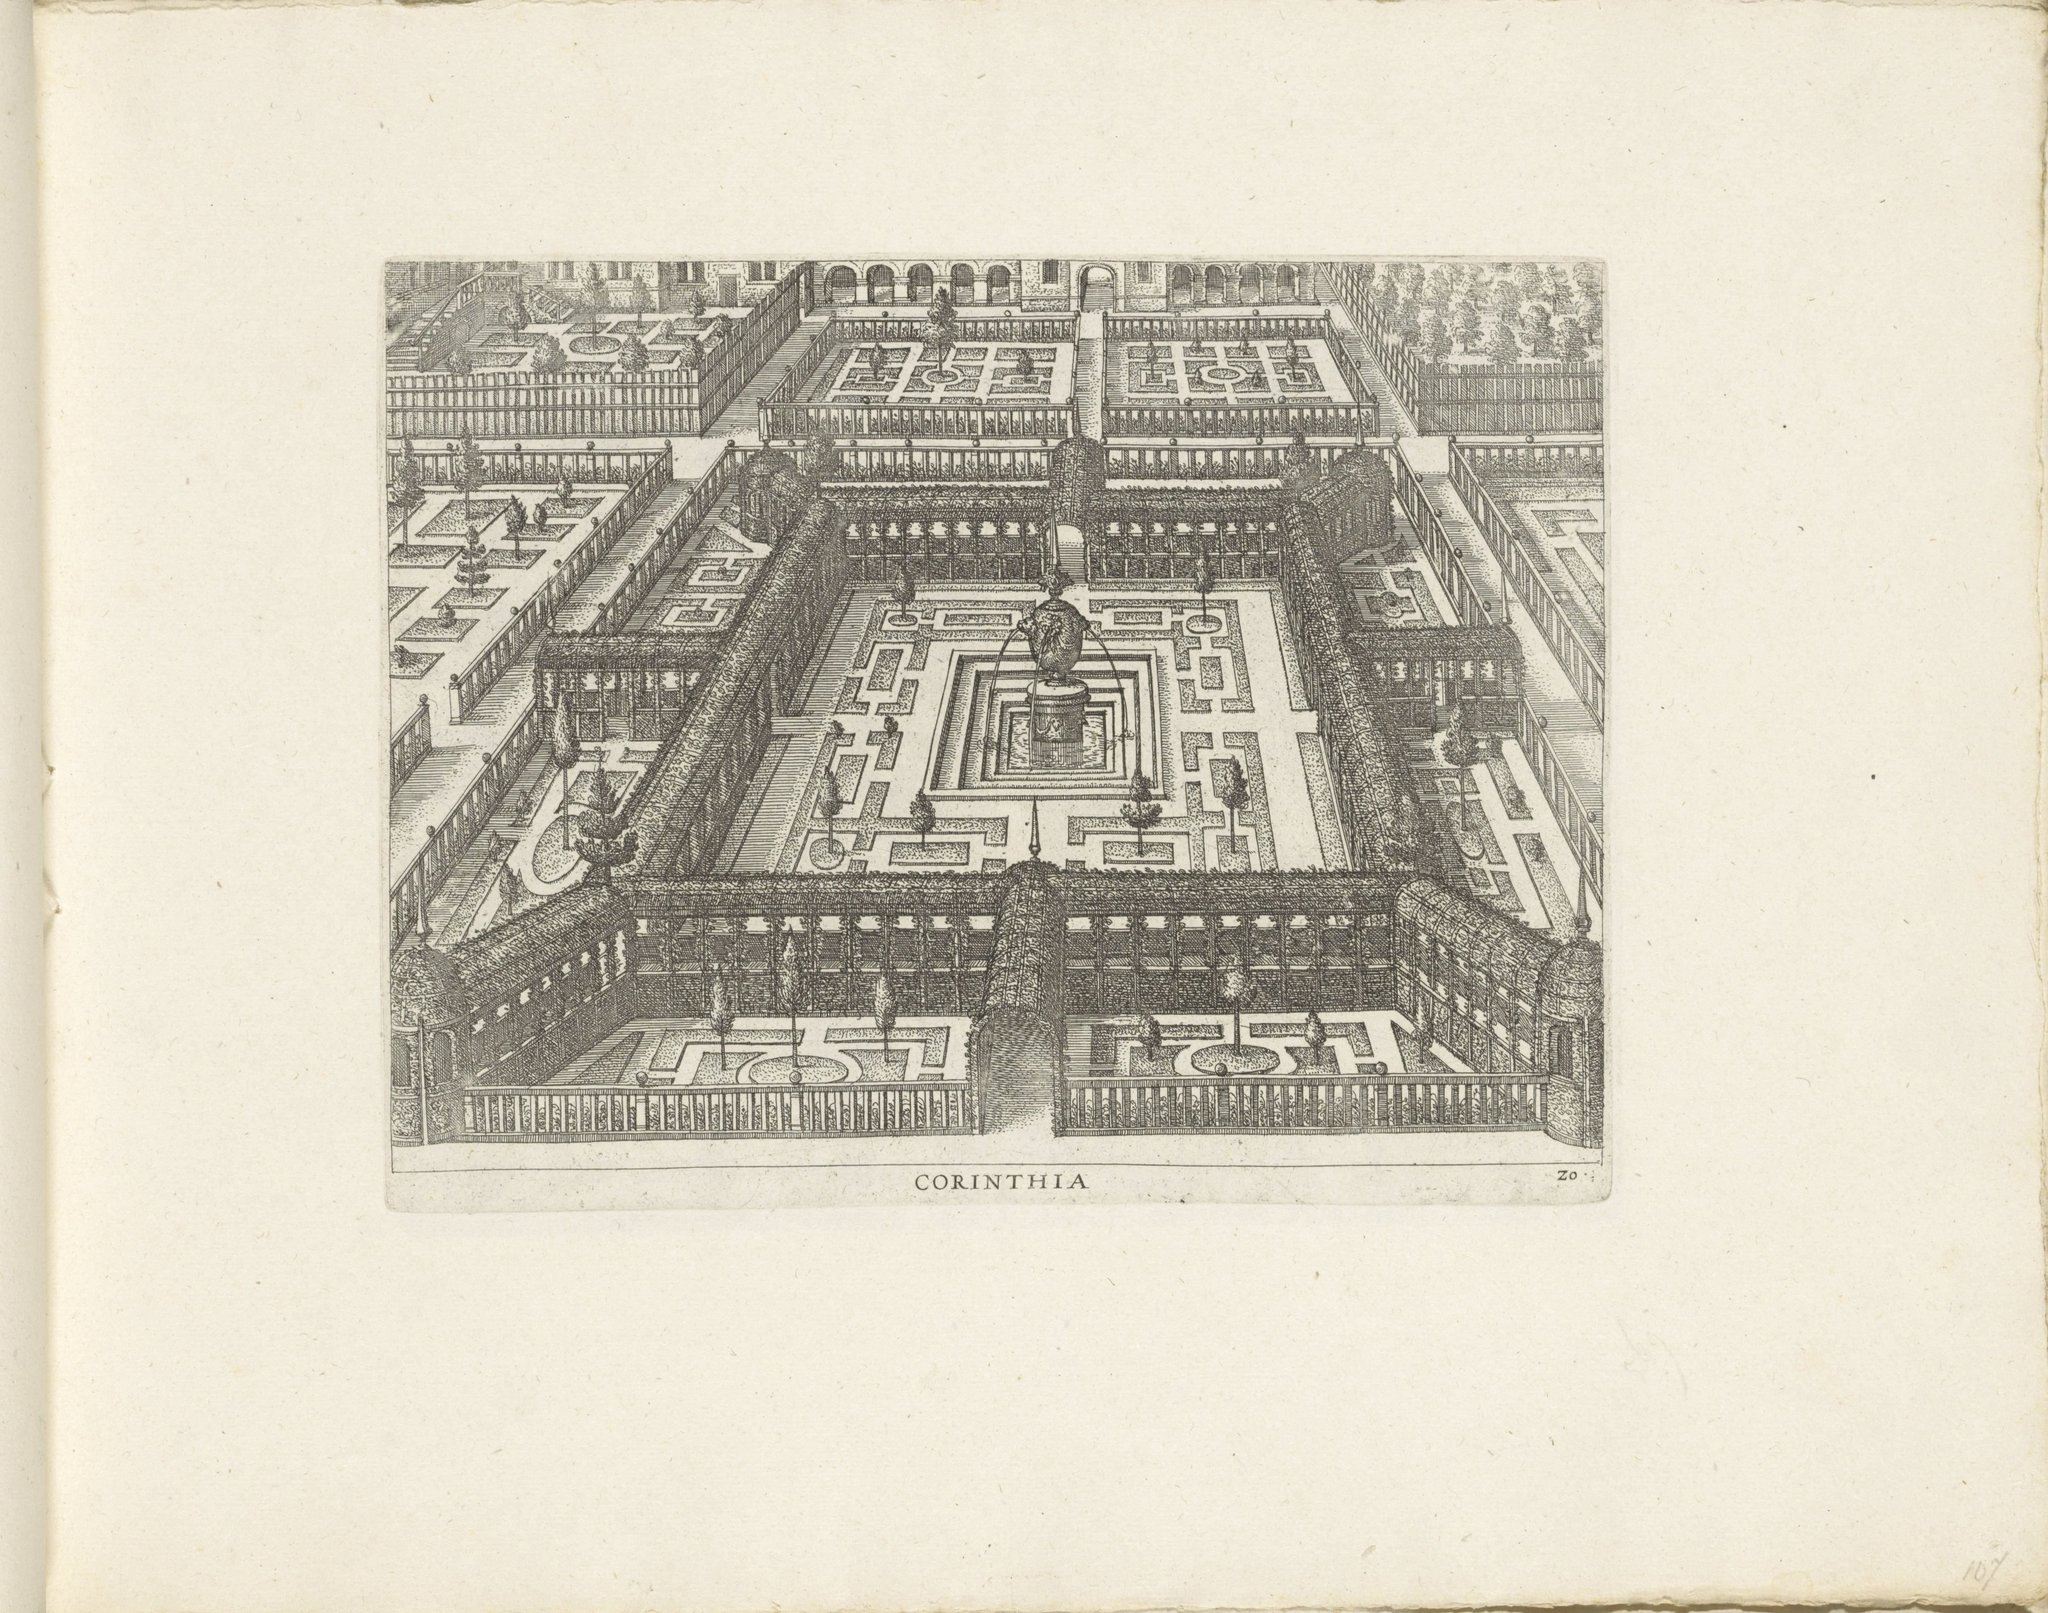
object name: print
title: Tuin met centrale parterre omgeven door een gang van traliewerk en in het midden een fontein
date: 1583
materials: paper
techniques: etching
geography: antwerp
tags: garden, french or architectonic garden; formal garden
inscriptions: collector's mark: Lugt 2228, collector's mark: Lugt 2760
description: De serie ‘Hortorum Viridariorumque’ van Vredeman de Vries (Hollstein Dutch 470-490) is in deze editie van de serie door uitgever Joannes Galle ( en eerder door zijn voorganger Theodoor Galle) aangevuld met de serie ‘Tuinen’ van Vredeman de Vries (Hollstein Dutch 508-515) en met twee prenten van Pieter van der Borcht (I) (New Hollstein Dutch 161-162). De prenten zijn genummerd: 1-30. Origineel hoort bij deze editie van de serie, uitgegeven door Joannes Galle, nog een prent van Van der Borcht met nummer 31, maar deze prent ontbreekt in deze serie in de collectie van het Rijksmuseum.